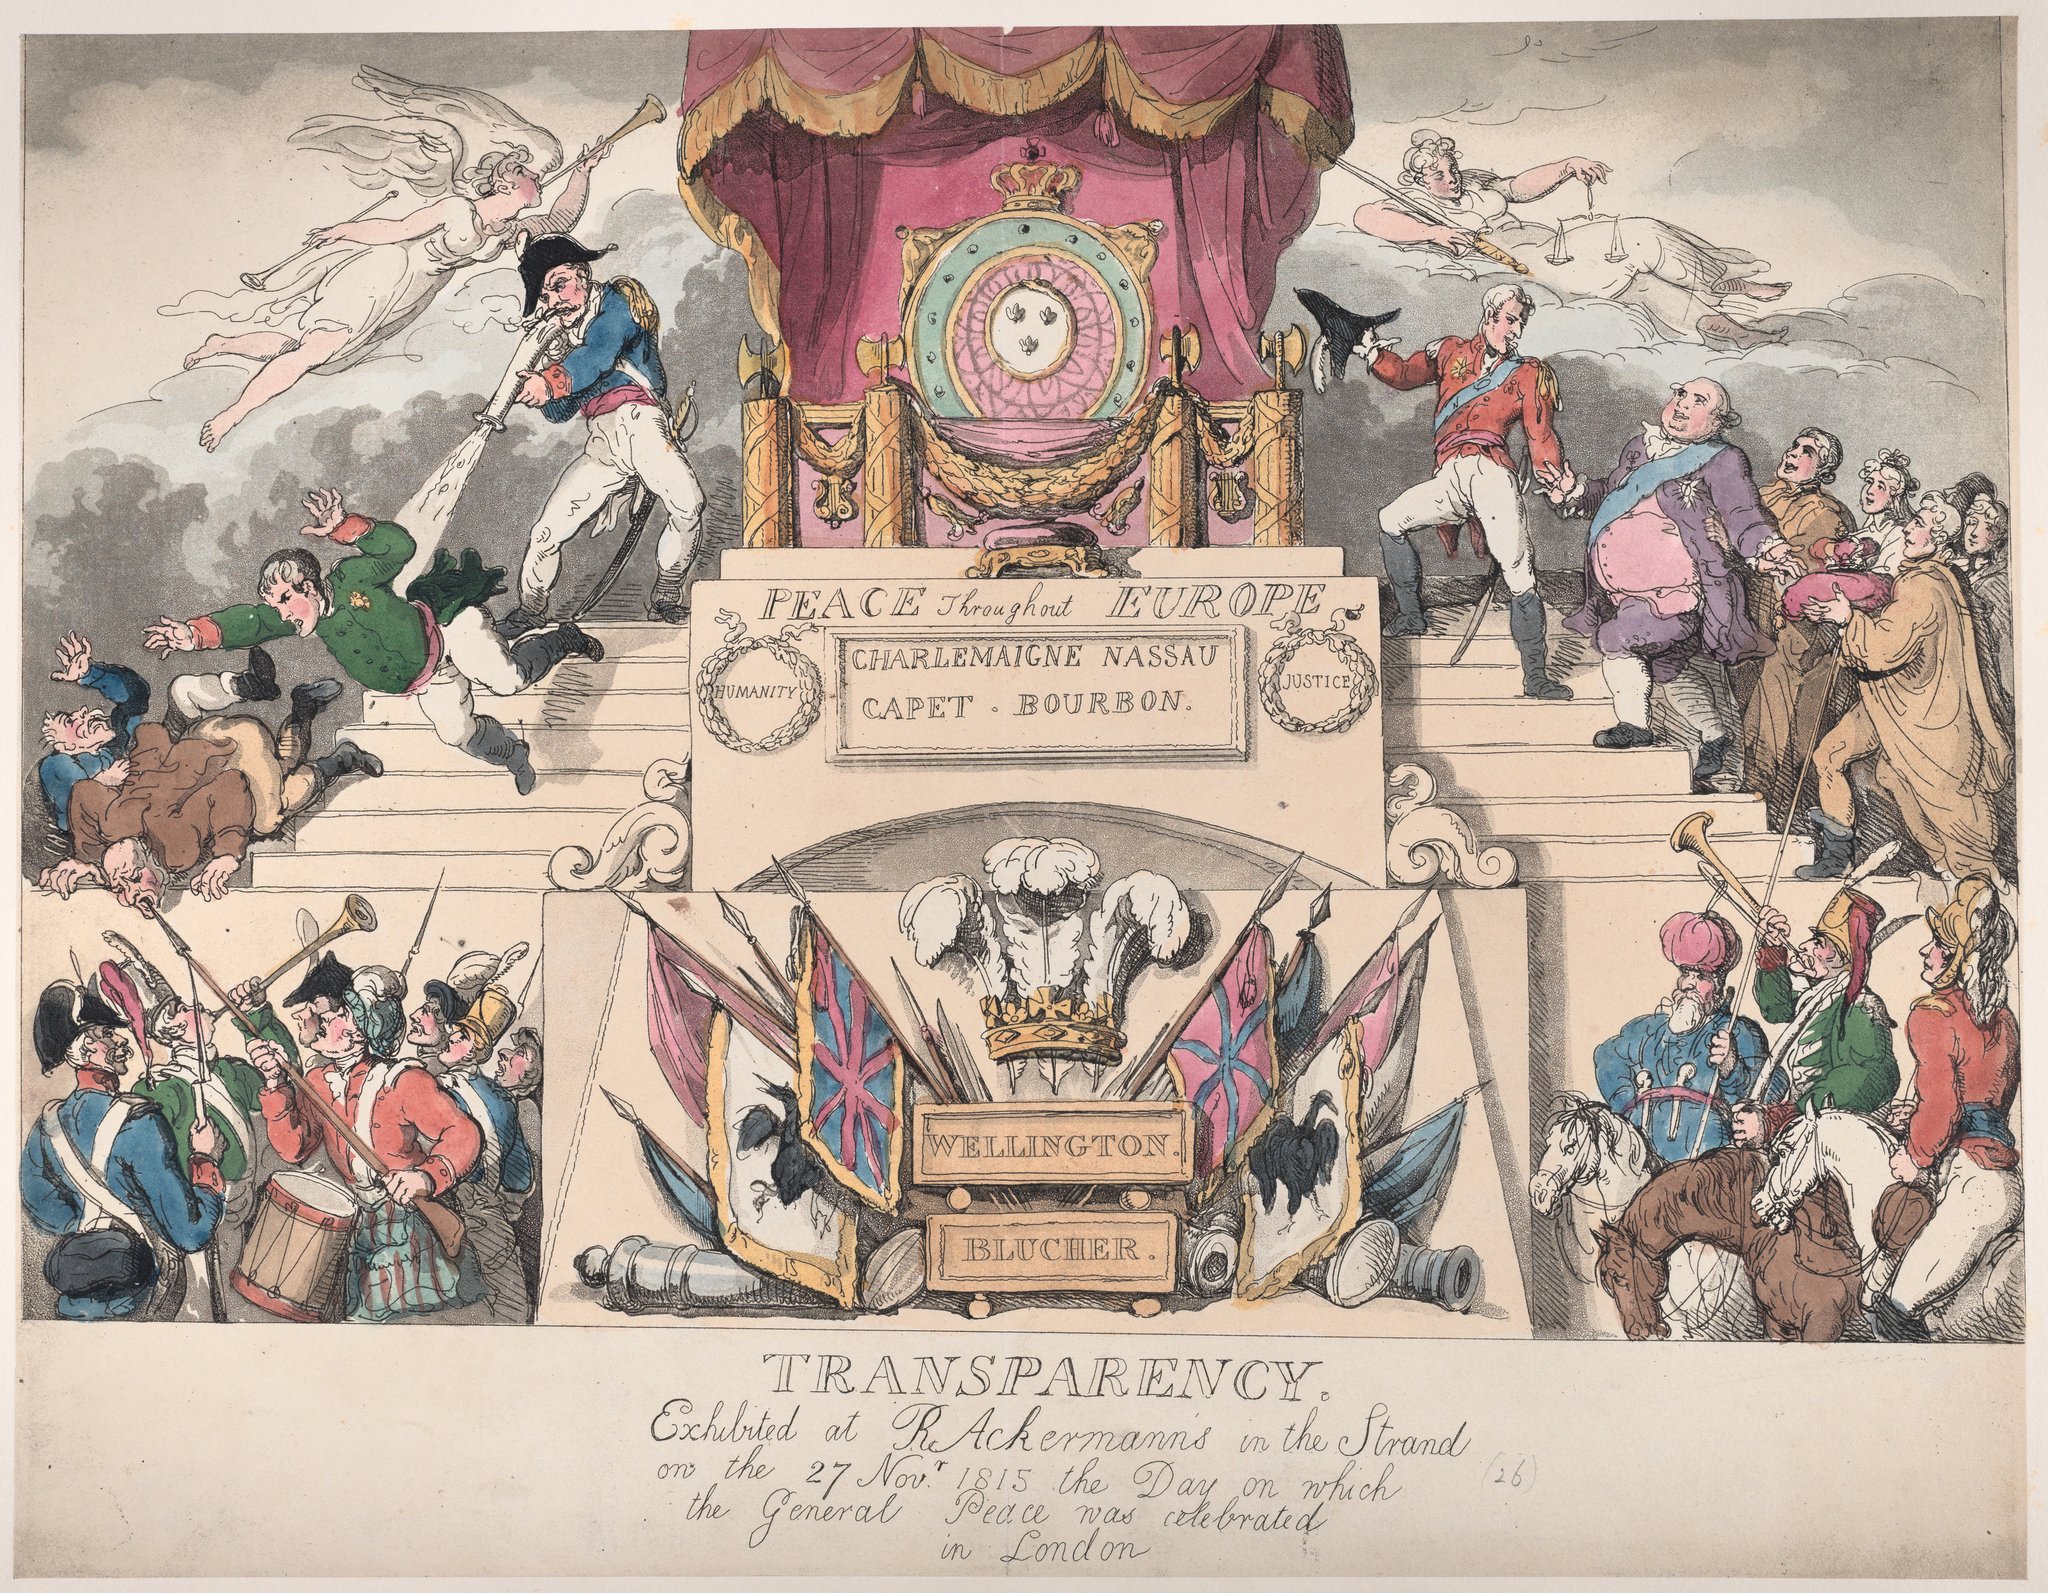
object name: print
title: Transparency: Exhibited at R. Ackermann's in the Strand on the 27th November 1815, the Day on which the General Peace was Celebrated in London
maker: thomas rowlandson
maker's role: artist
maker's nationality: british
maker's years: 1757-1827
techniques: etching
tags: satire,napoleon i,politics